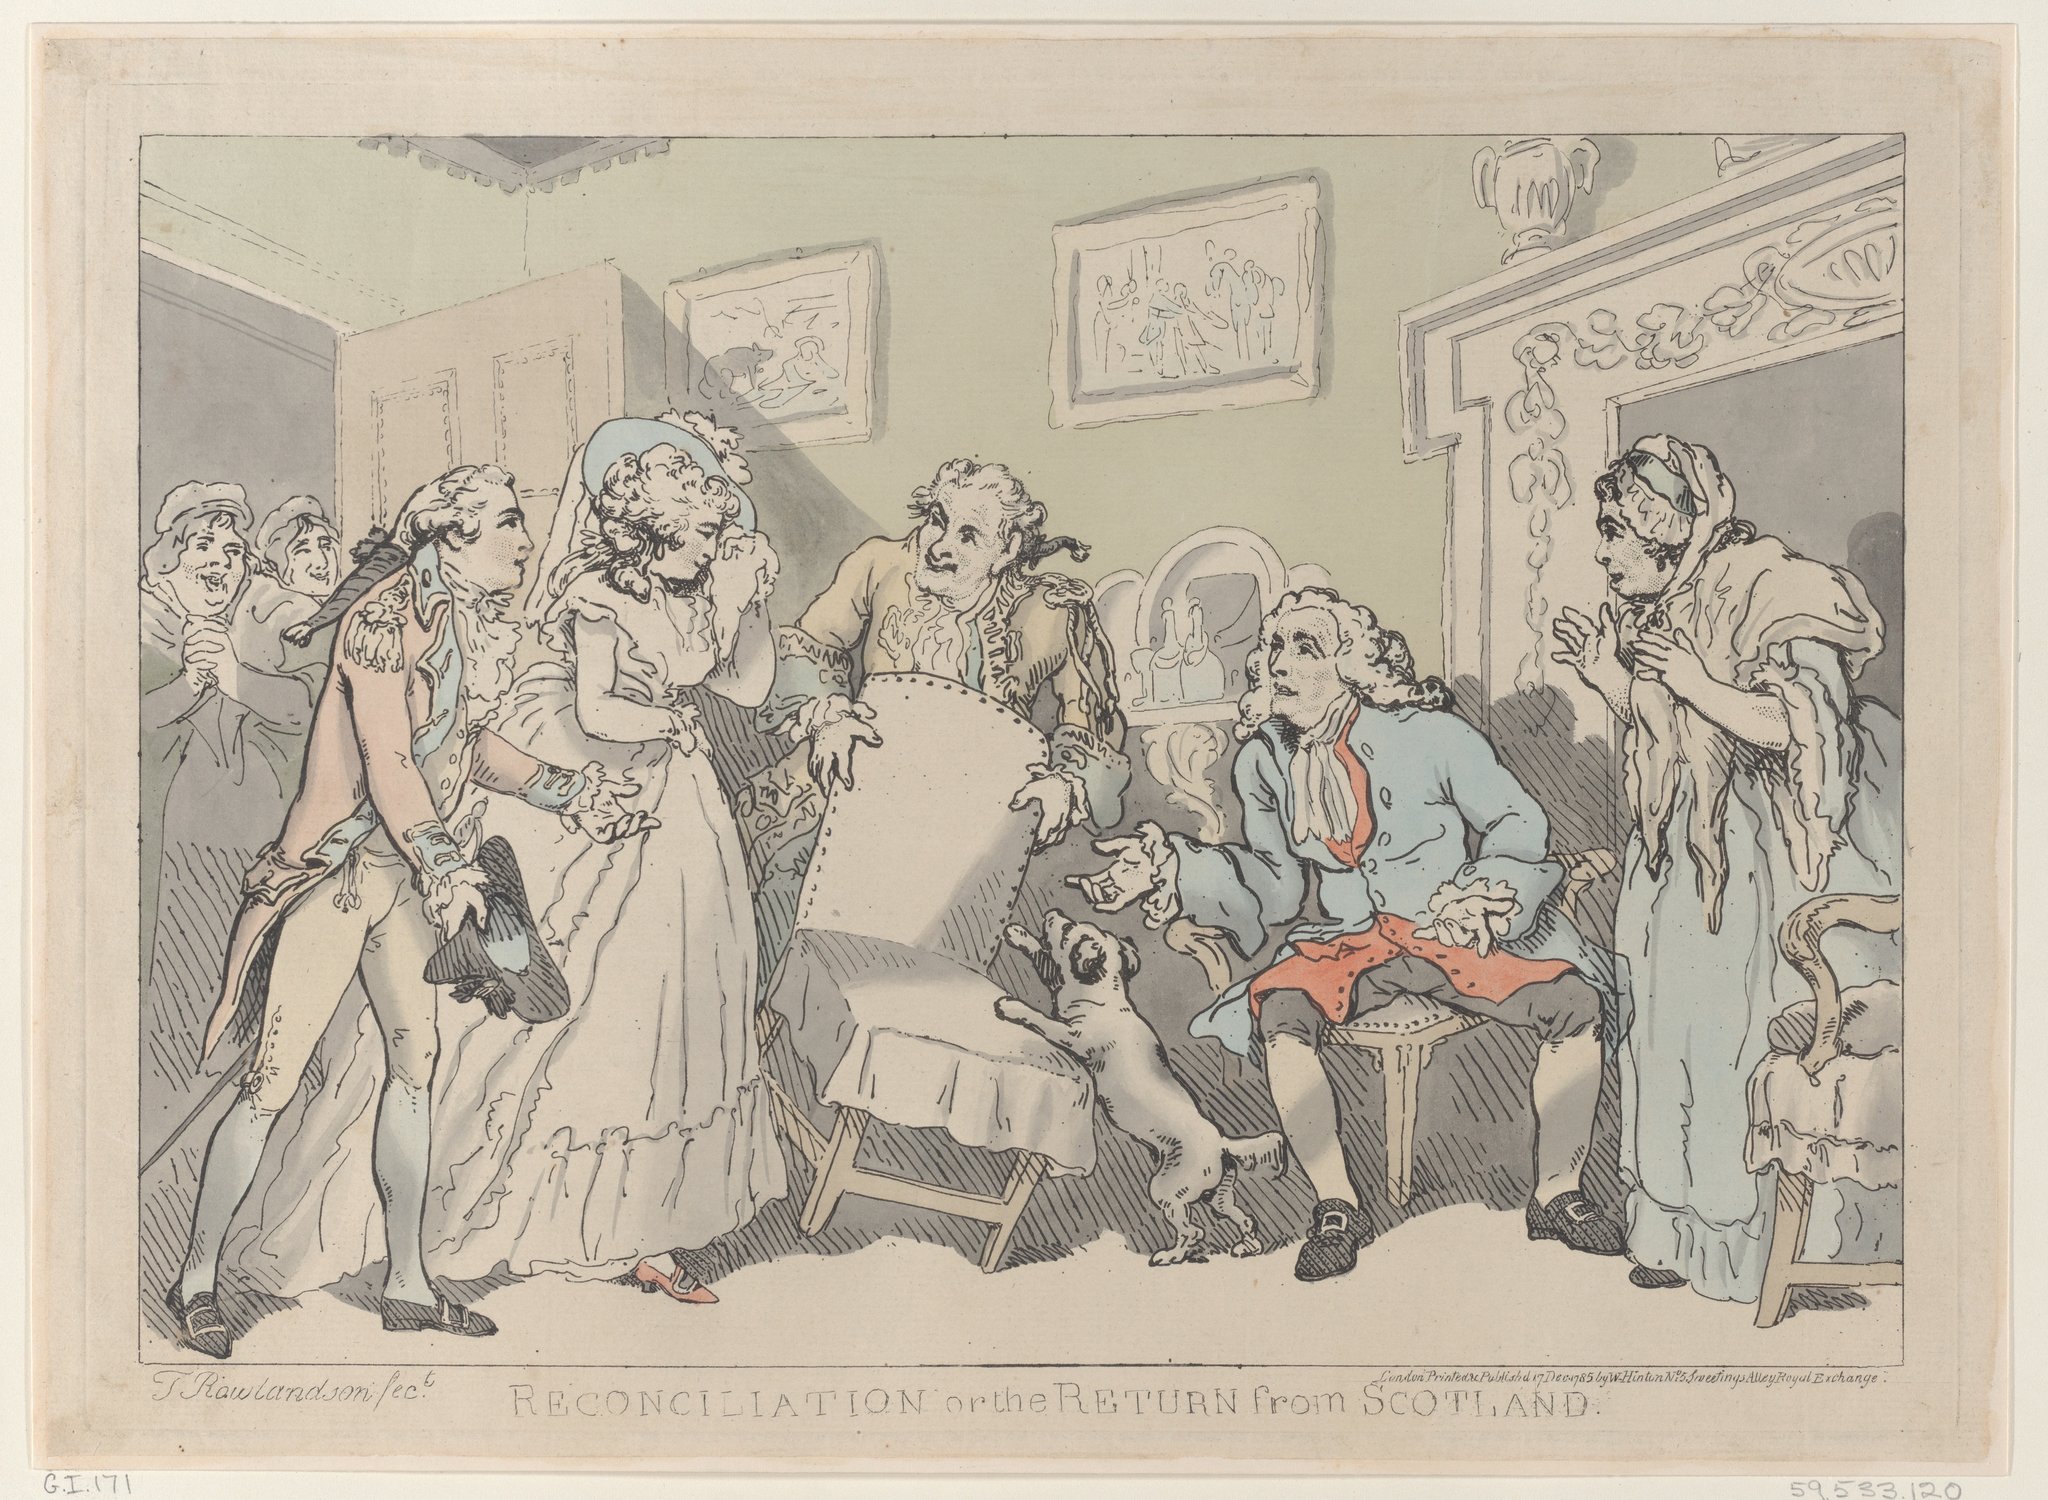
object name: print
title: Reconciliation, or the Return from Scotland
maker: thomas rowlandson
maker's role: artist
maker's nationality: british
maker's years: 1757-1827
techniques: etching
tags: satire,men,women,dogs